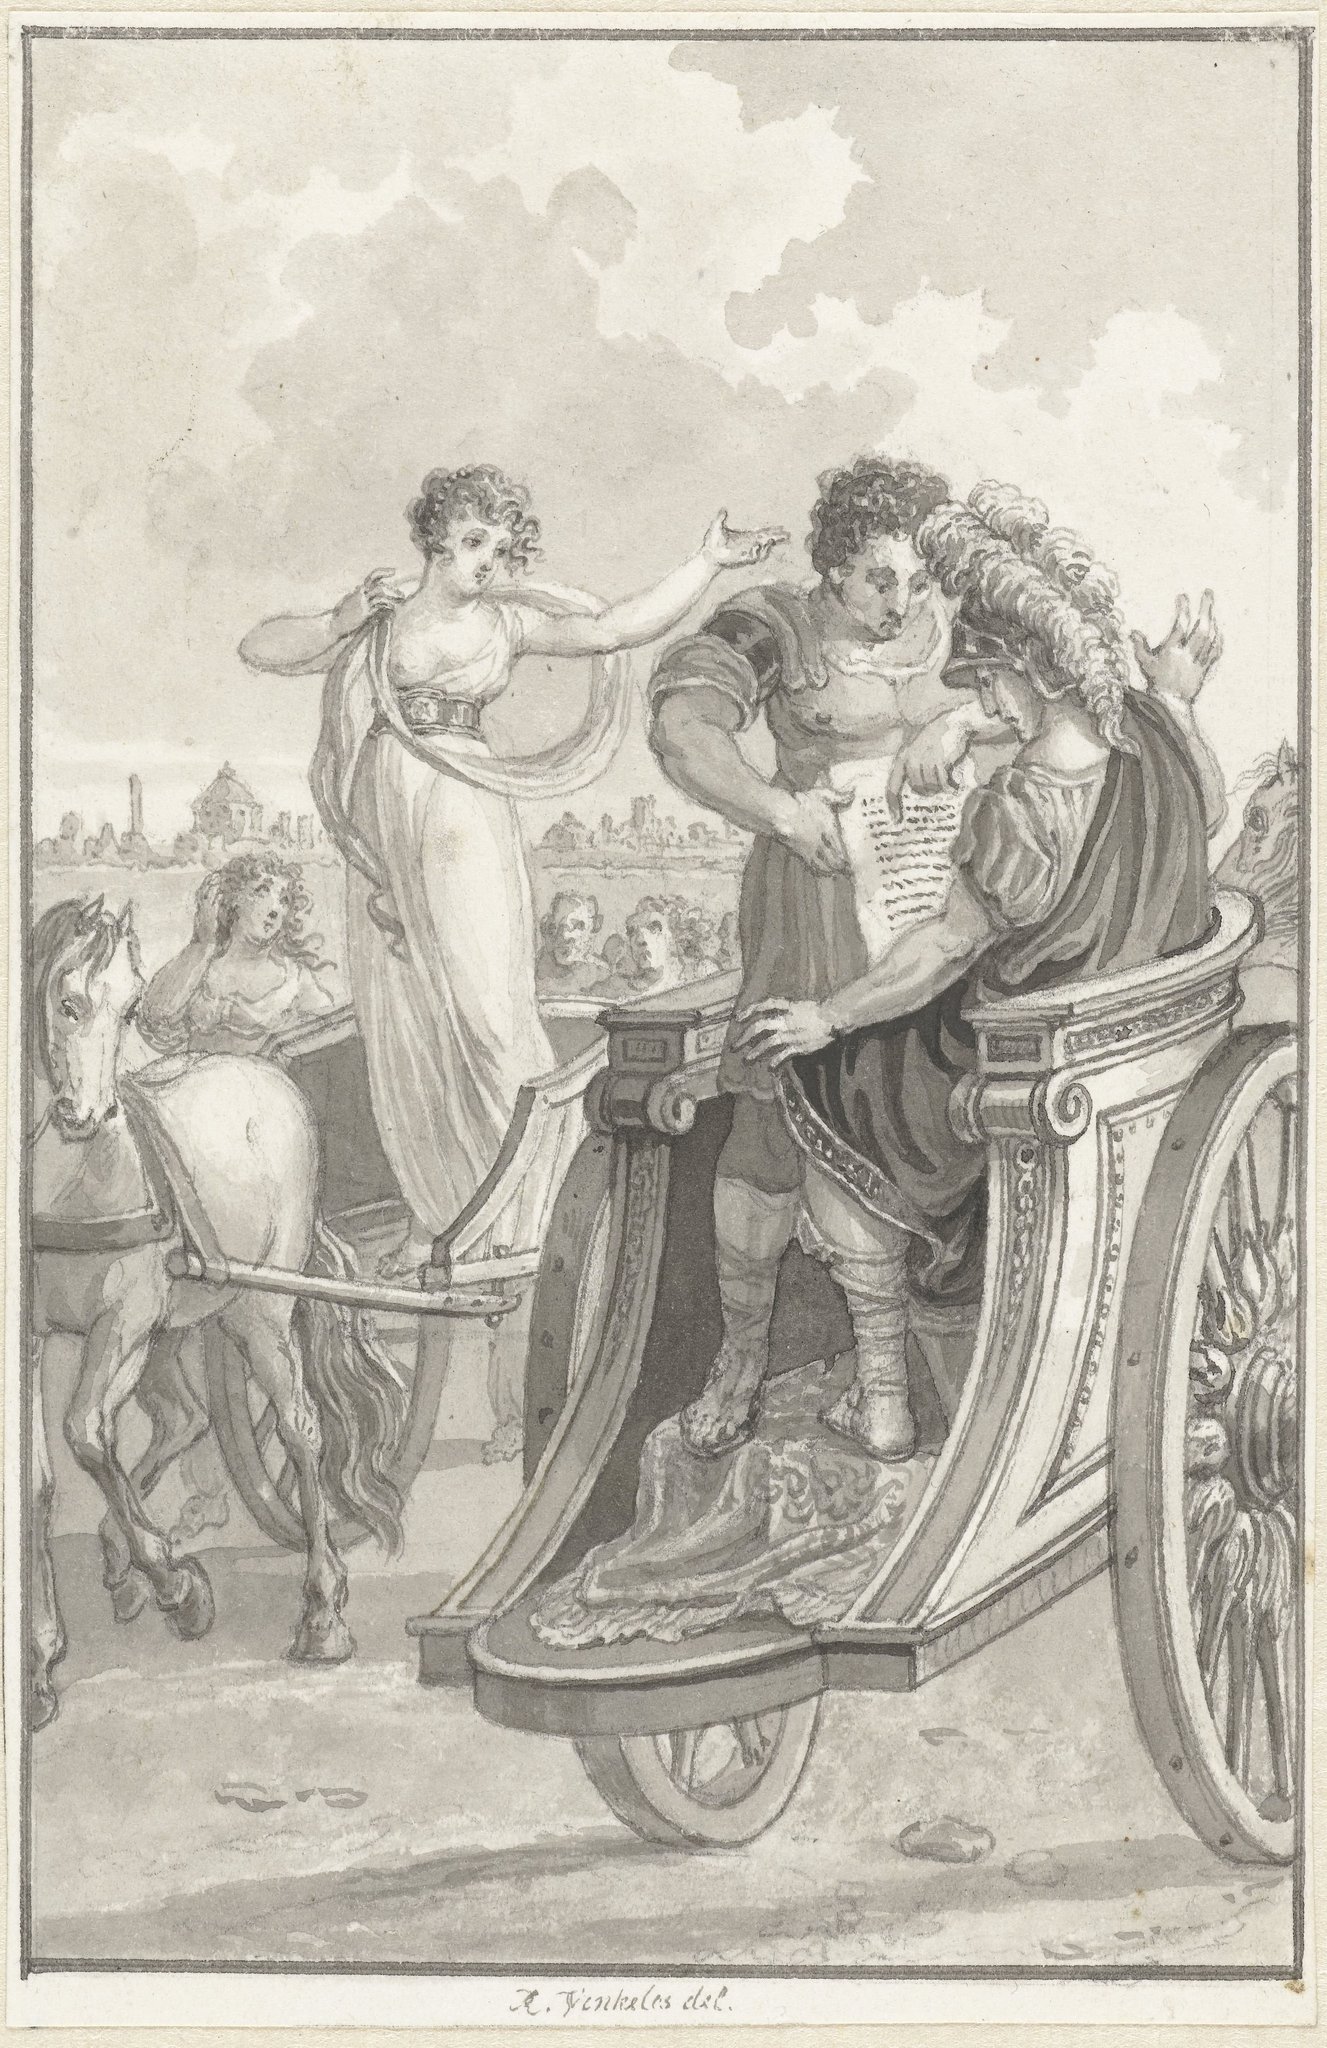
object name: drawing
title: De val van Messalina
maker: reinier vinkeles (i)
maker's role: draughtsman, print maker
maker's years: 1741-1816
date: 1804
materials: ink, paper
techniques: brush, pen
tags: love-affairs of messalina, (story of) claudius the roman emperor - love-affairs of person from classical history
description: De val van Messalina; in zijn strijdwagen krijgt keizer Claudius de beschuldigingen tegen de keizerin te lezen.